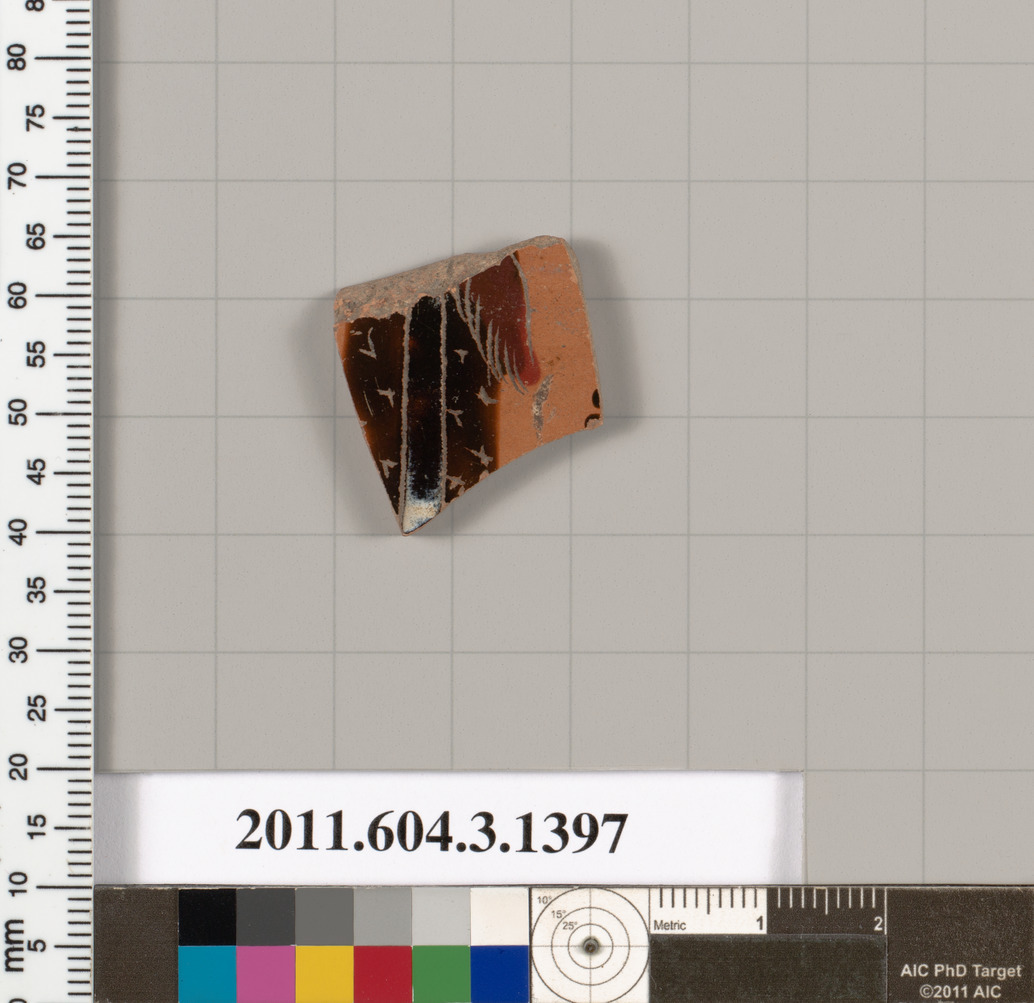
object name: skyphos fragment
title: Terracotta fragment of a skyphos (deep drinking cup)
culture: greek, attic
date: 534-501 BCE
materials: terracotta